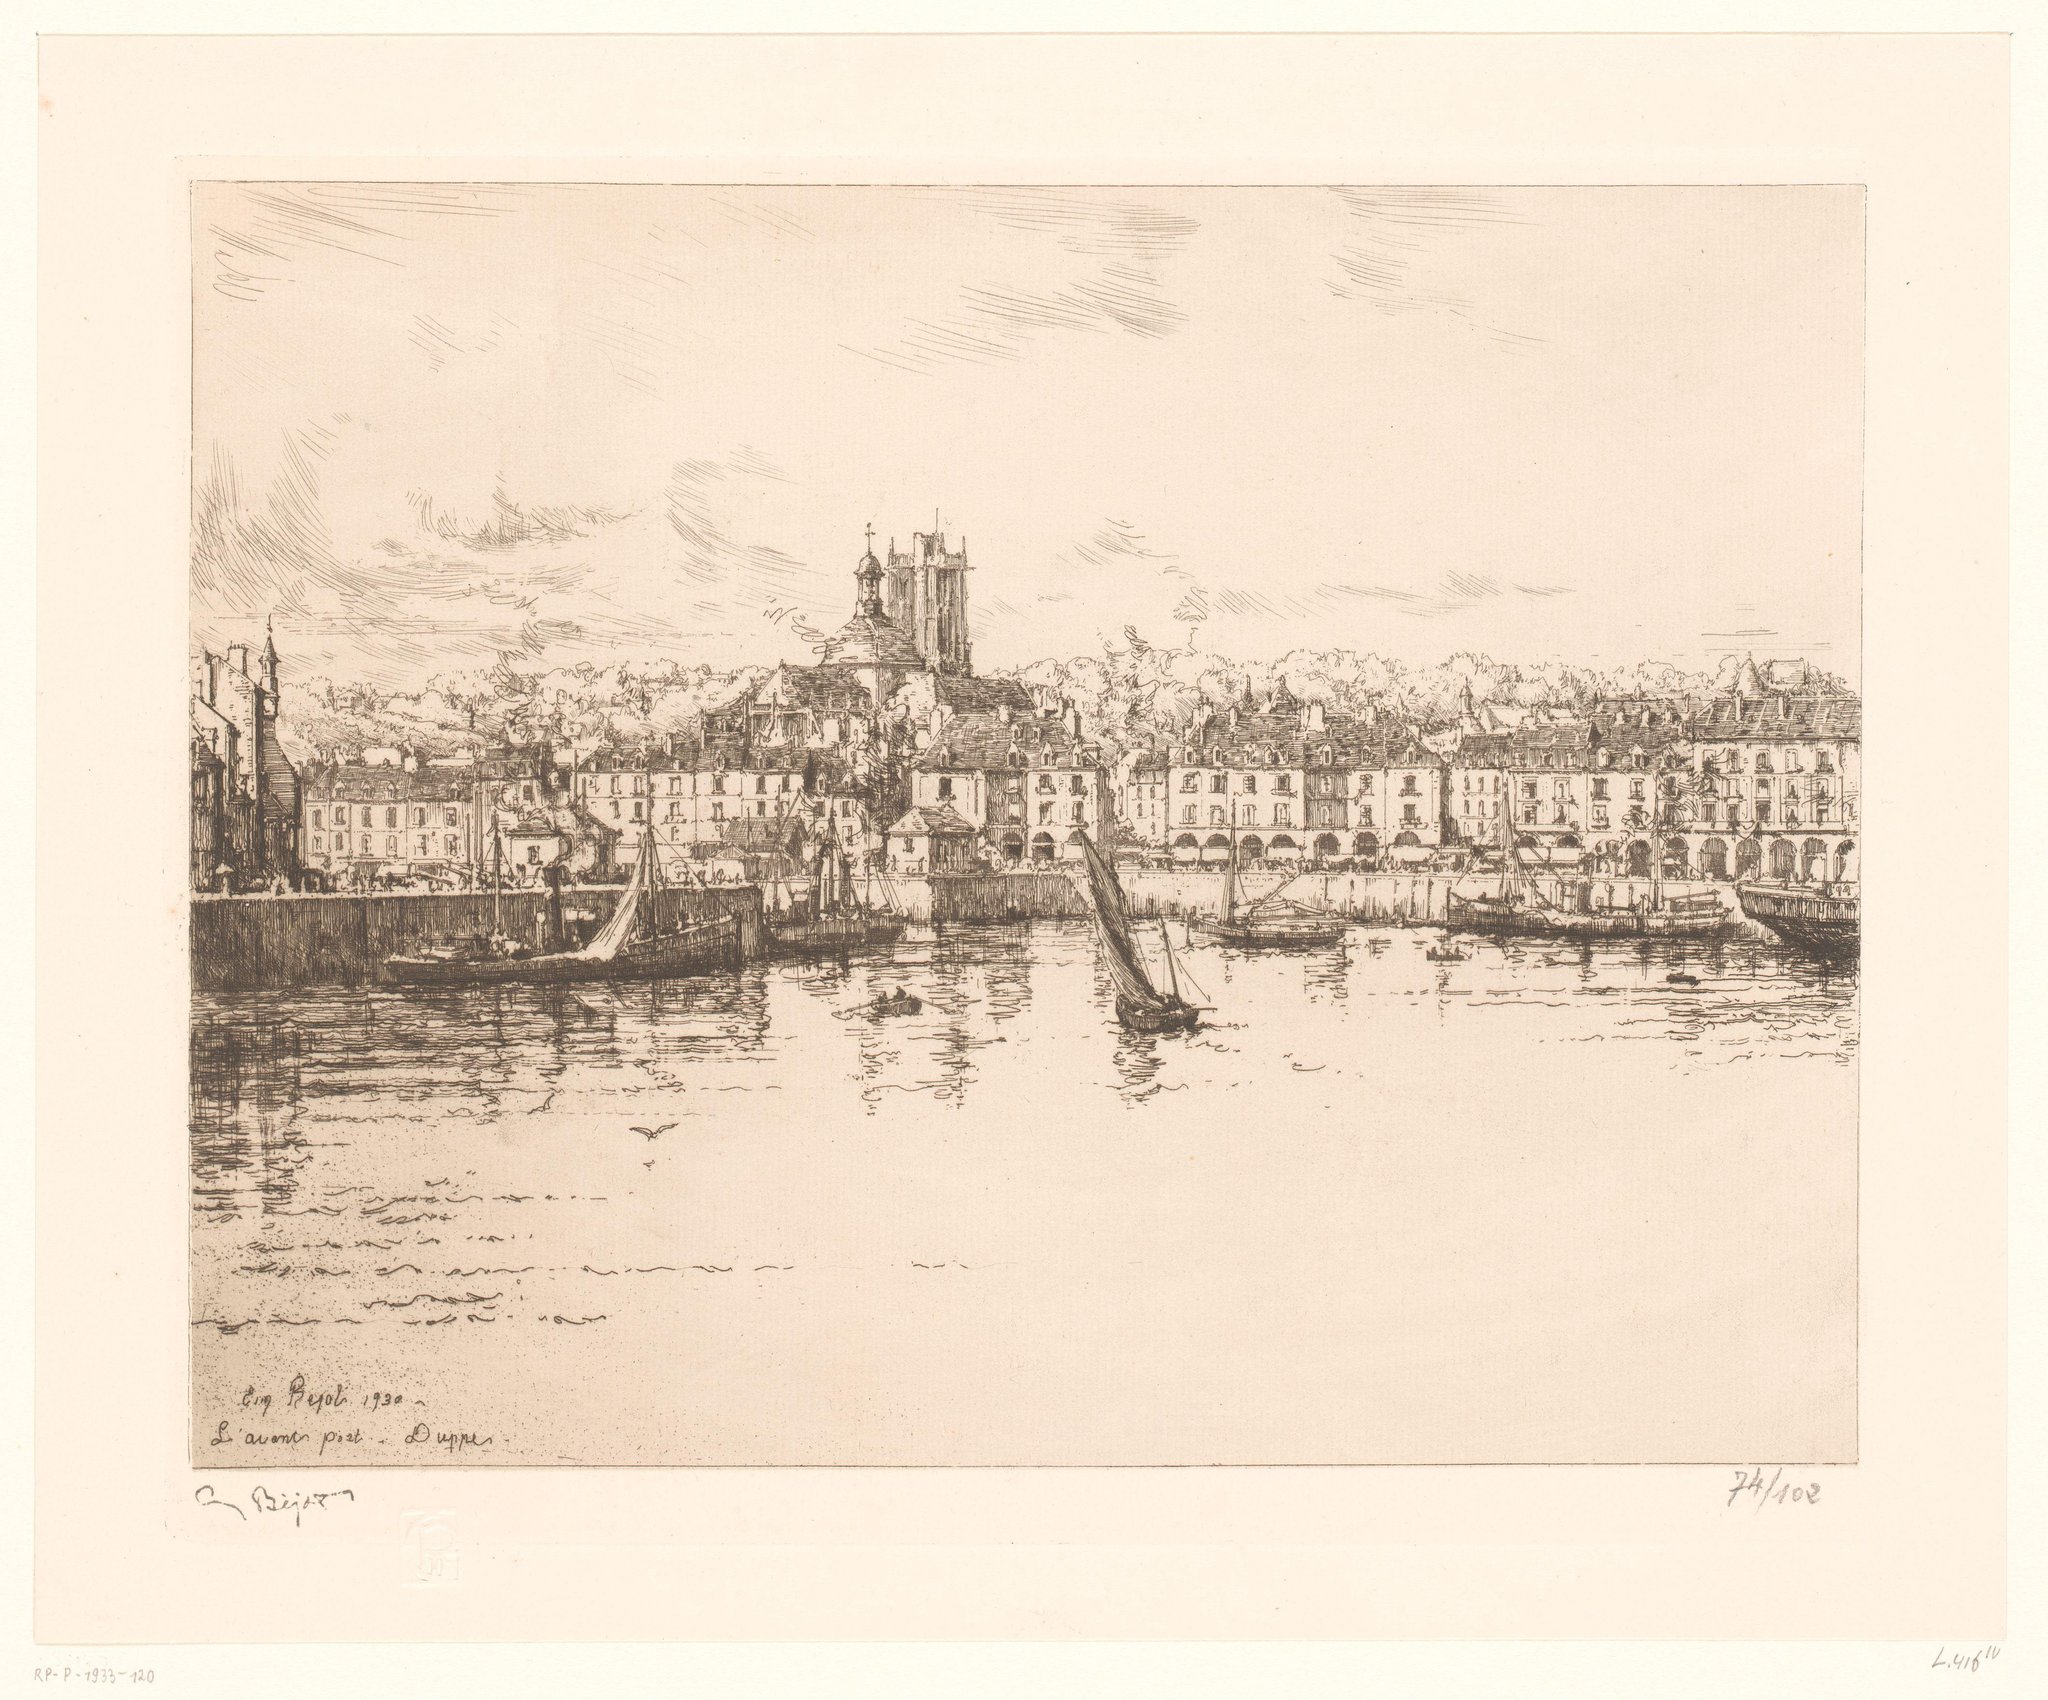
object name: print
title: L'avant port Dieppe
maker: eugène bejot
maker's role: print maker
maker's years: 1867-1931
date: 1930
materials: paper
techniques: drypoint, etching, intaglio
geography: dieppe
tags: harbour, ships (in general) - cc - more than one ship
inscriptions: collector's mark: Lugt 2228, check stamp: Lugt 1195a